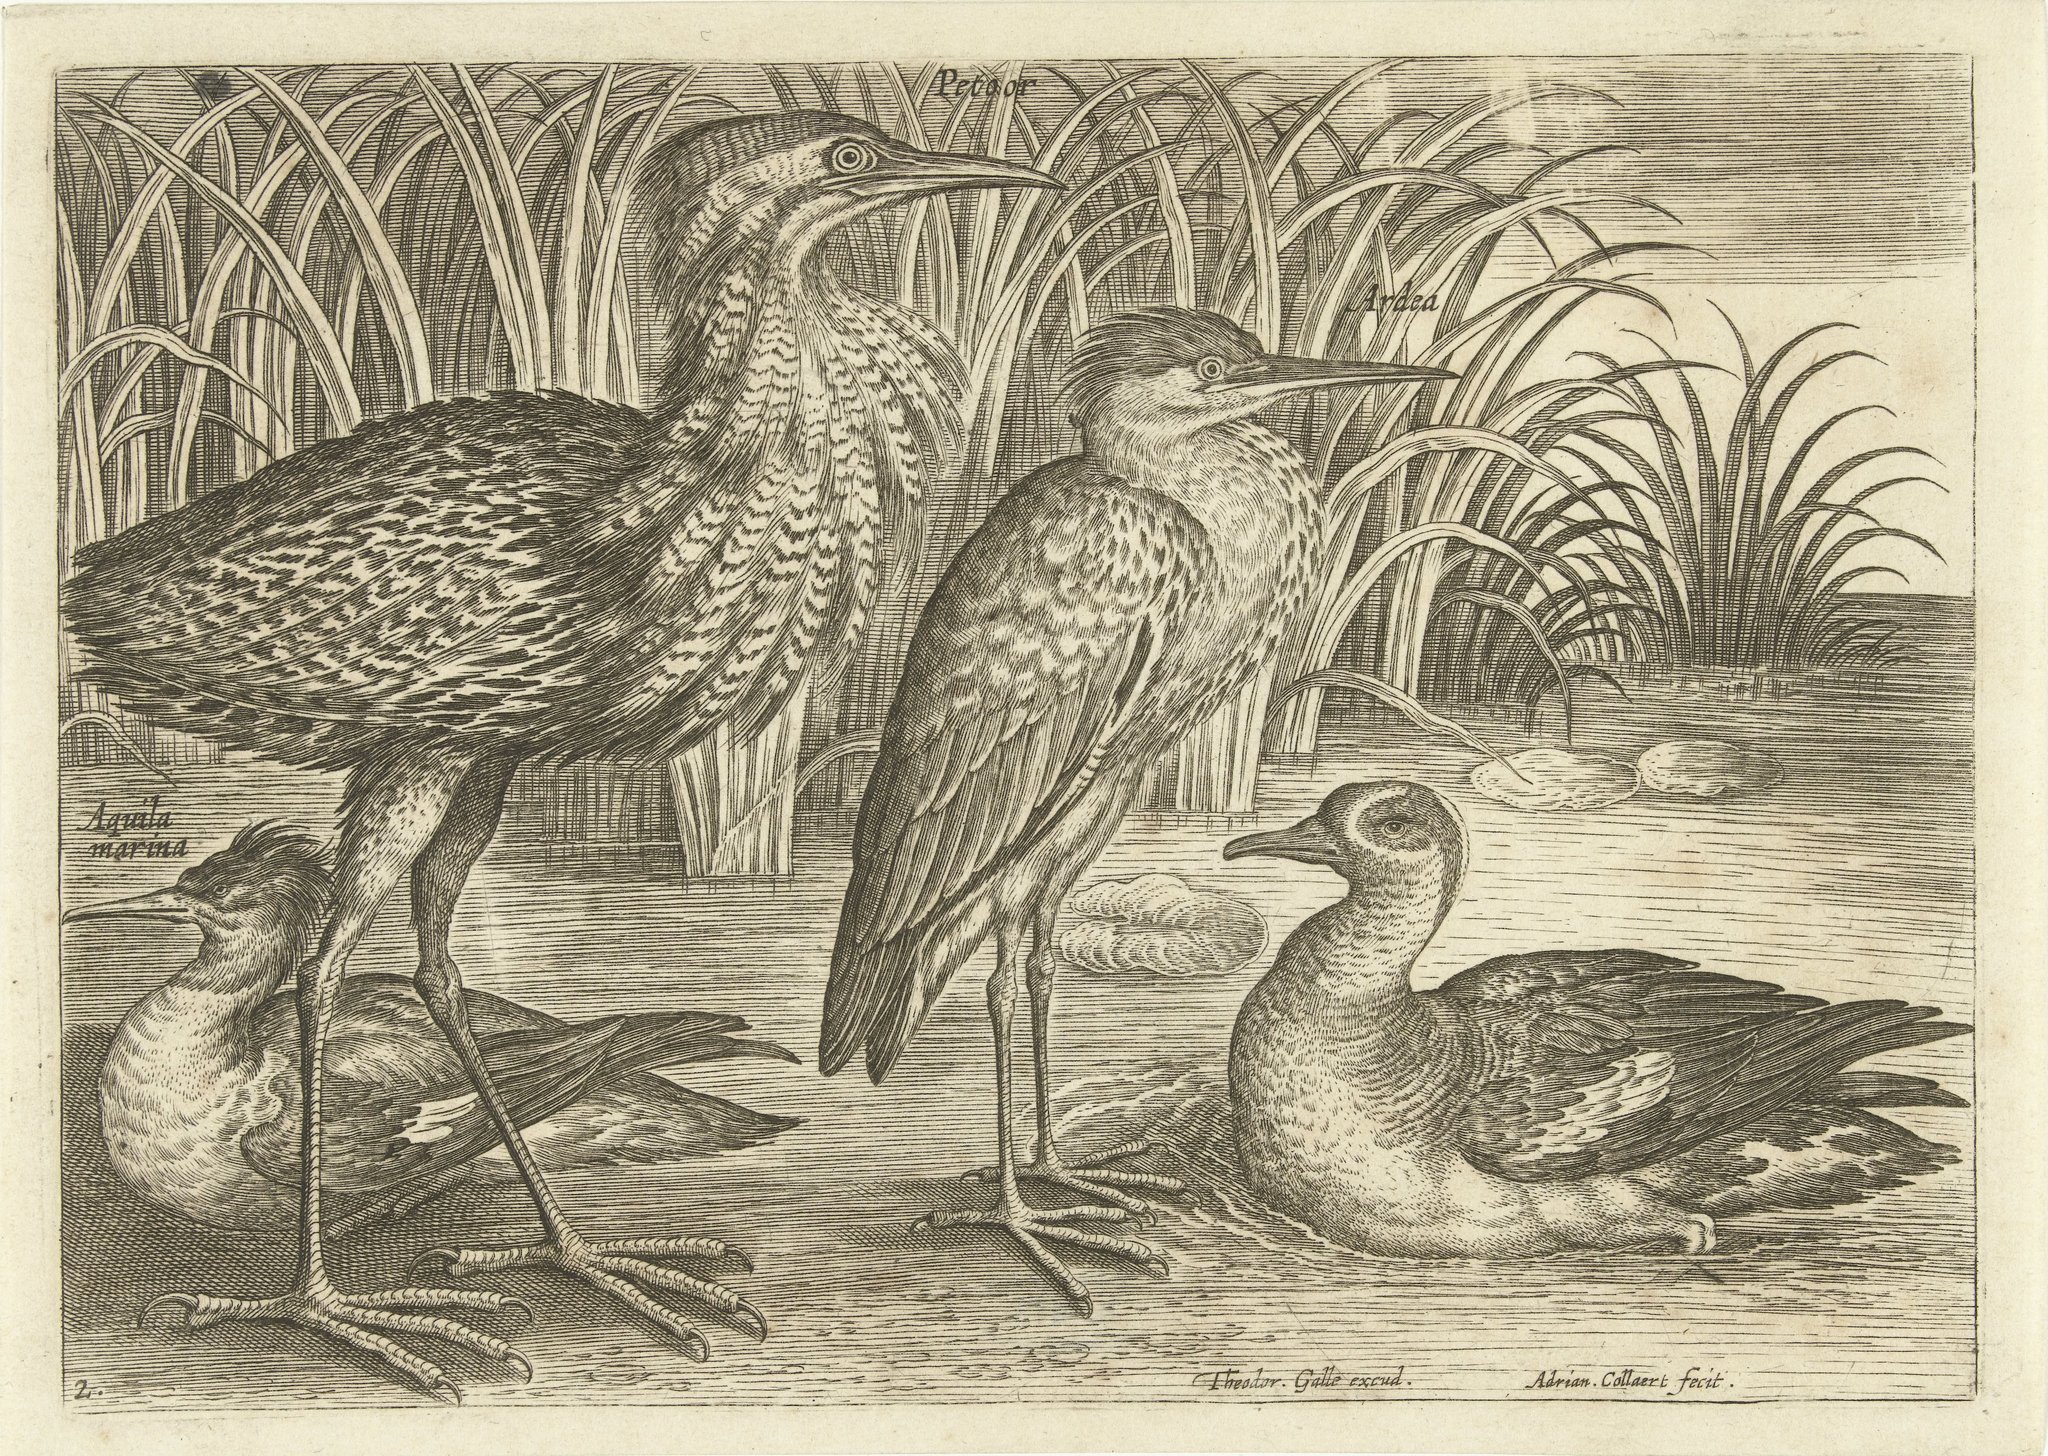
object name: print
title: Vogels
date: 1598-1618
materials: paper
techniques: engraving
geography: antwerp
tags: shore-birds and wading-birds: heron, water-birds: teal, shore-birds and wading-birds: sawbill, shore-birds and wading-birds: bittern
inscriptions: collector's mark: Lugt 2228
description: Vier waadvogels langs een oever: een middelste zaagbek, een roerdomp, een reiger en een taling. Deze prent is deel van een serie over vogels.